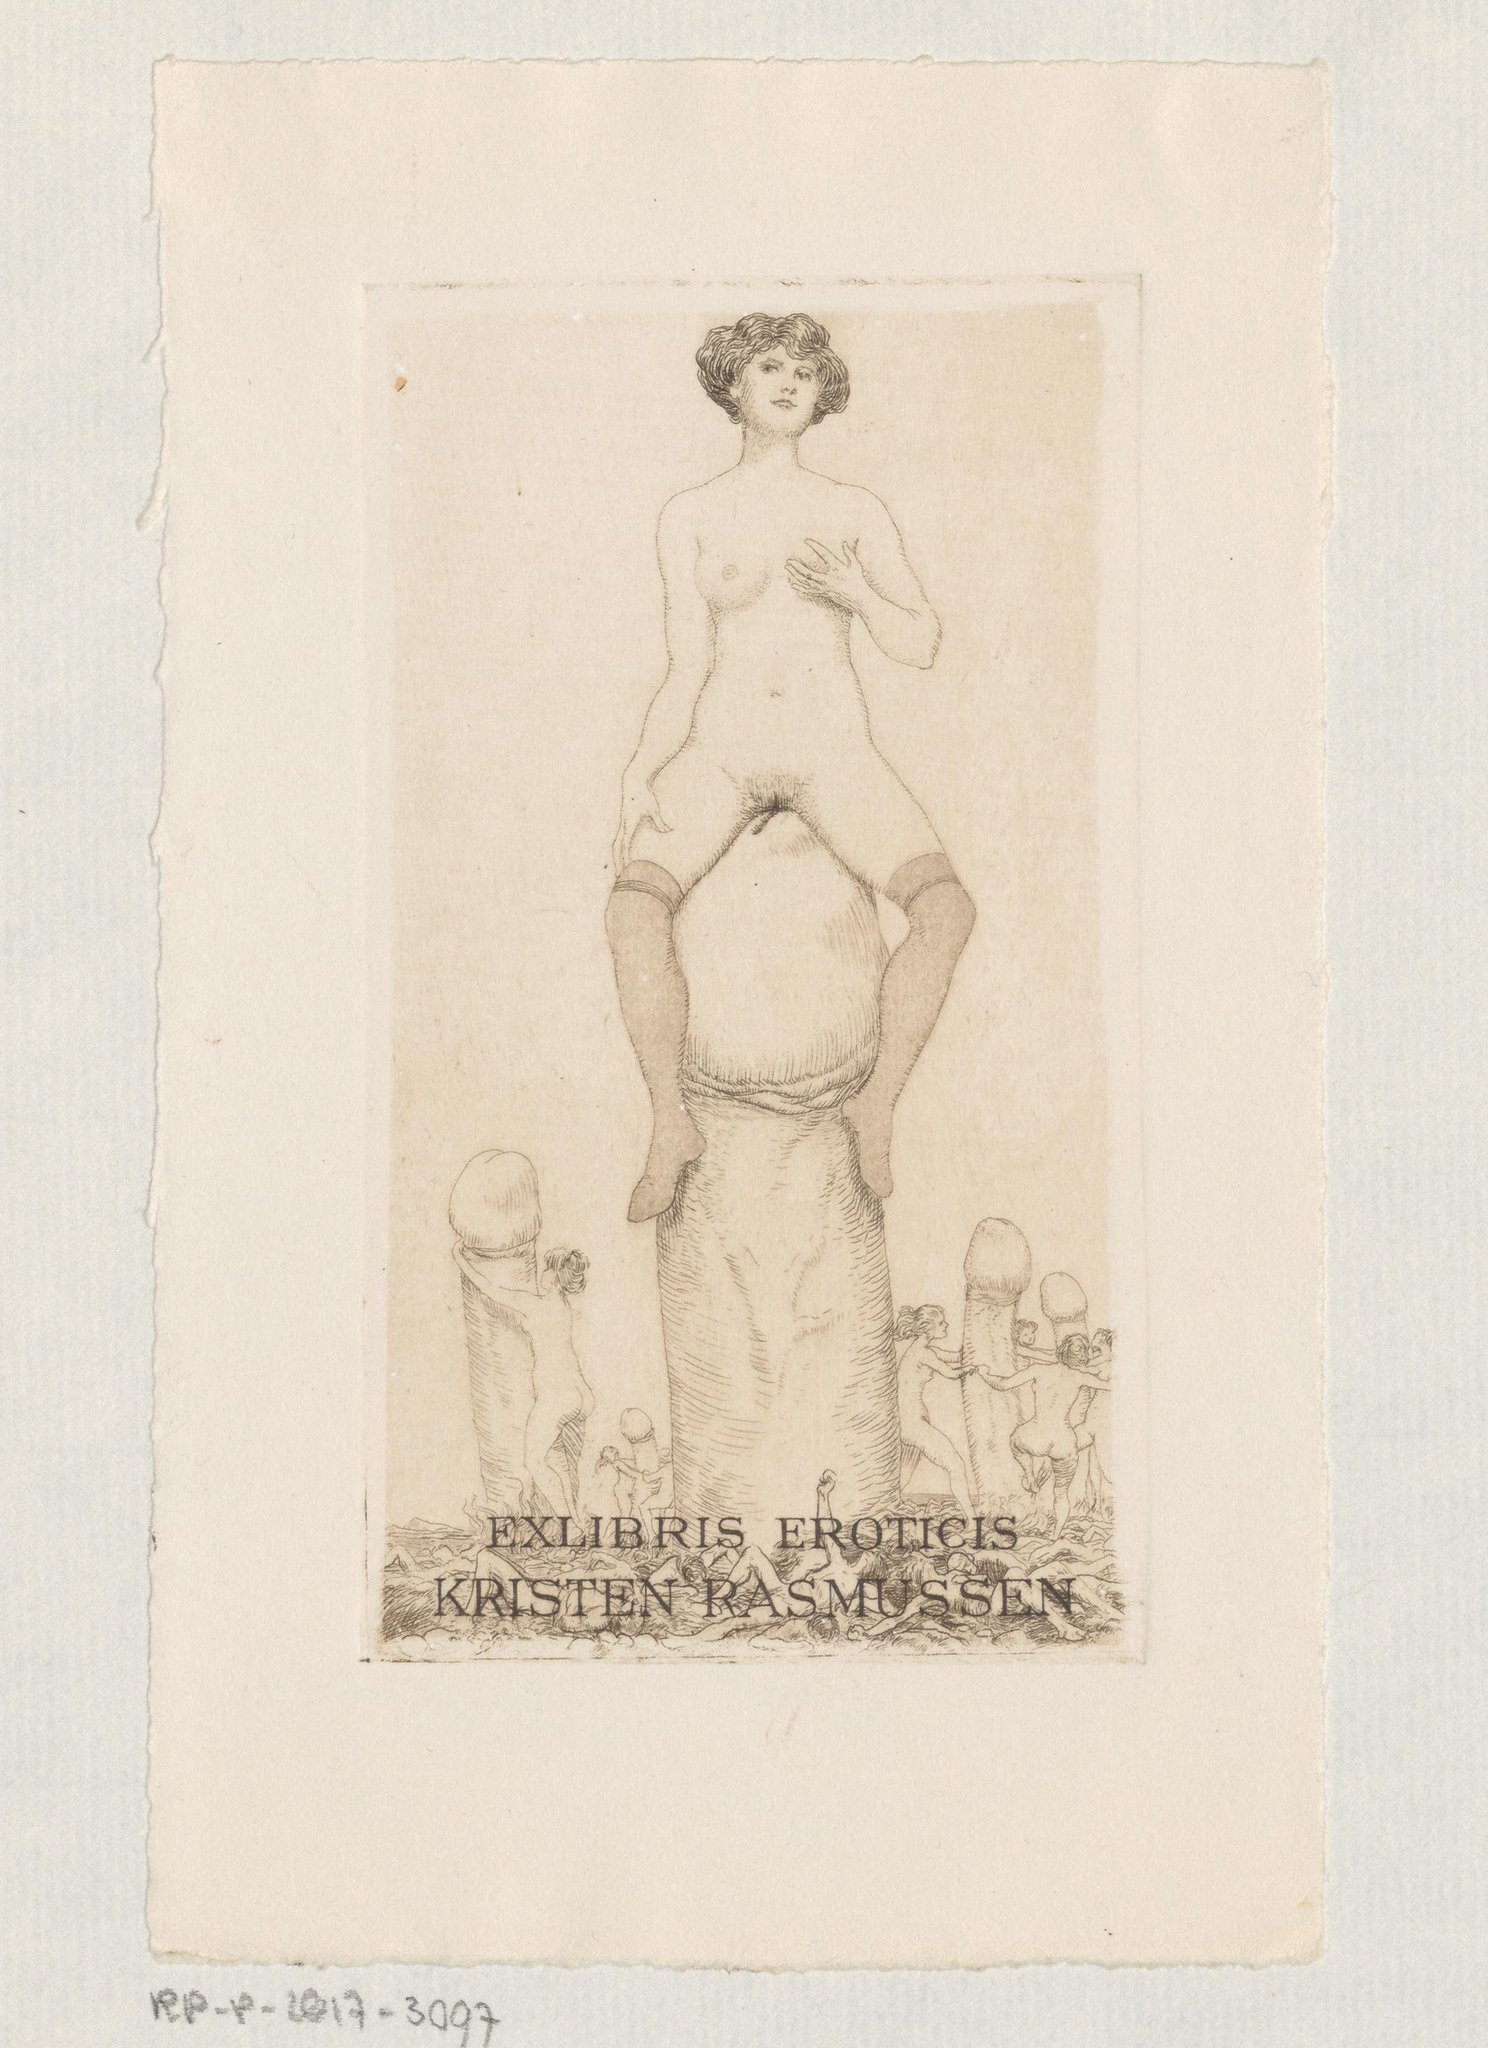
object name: bookplate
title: Ex libris van Kristen Rasmussen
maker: fritz mock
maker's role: painter, print maker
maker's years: 1867-1919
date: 1877-1919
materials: paper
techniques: etching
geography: switzerland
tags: woman (showing herself) undressed, quasi-nude, penis, phallus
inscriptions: inscription: ‘Ex.dr. Klüber / Fritz Mock (Schweiz)’